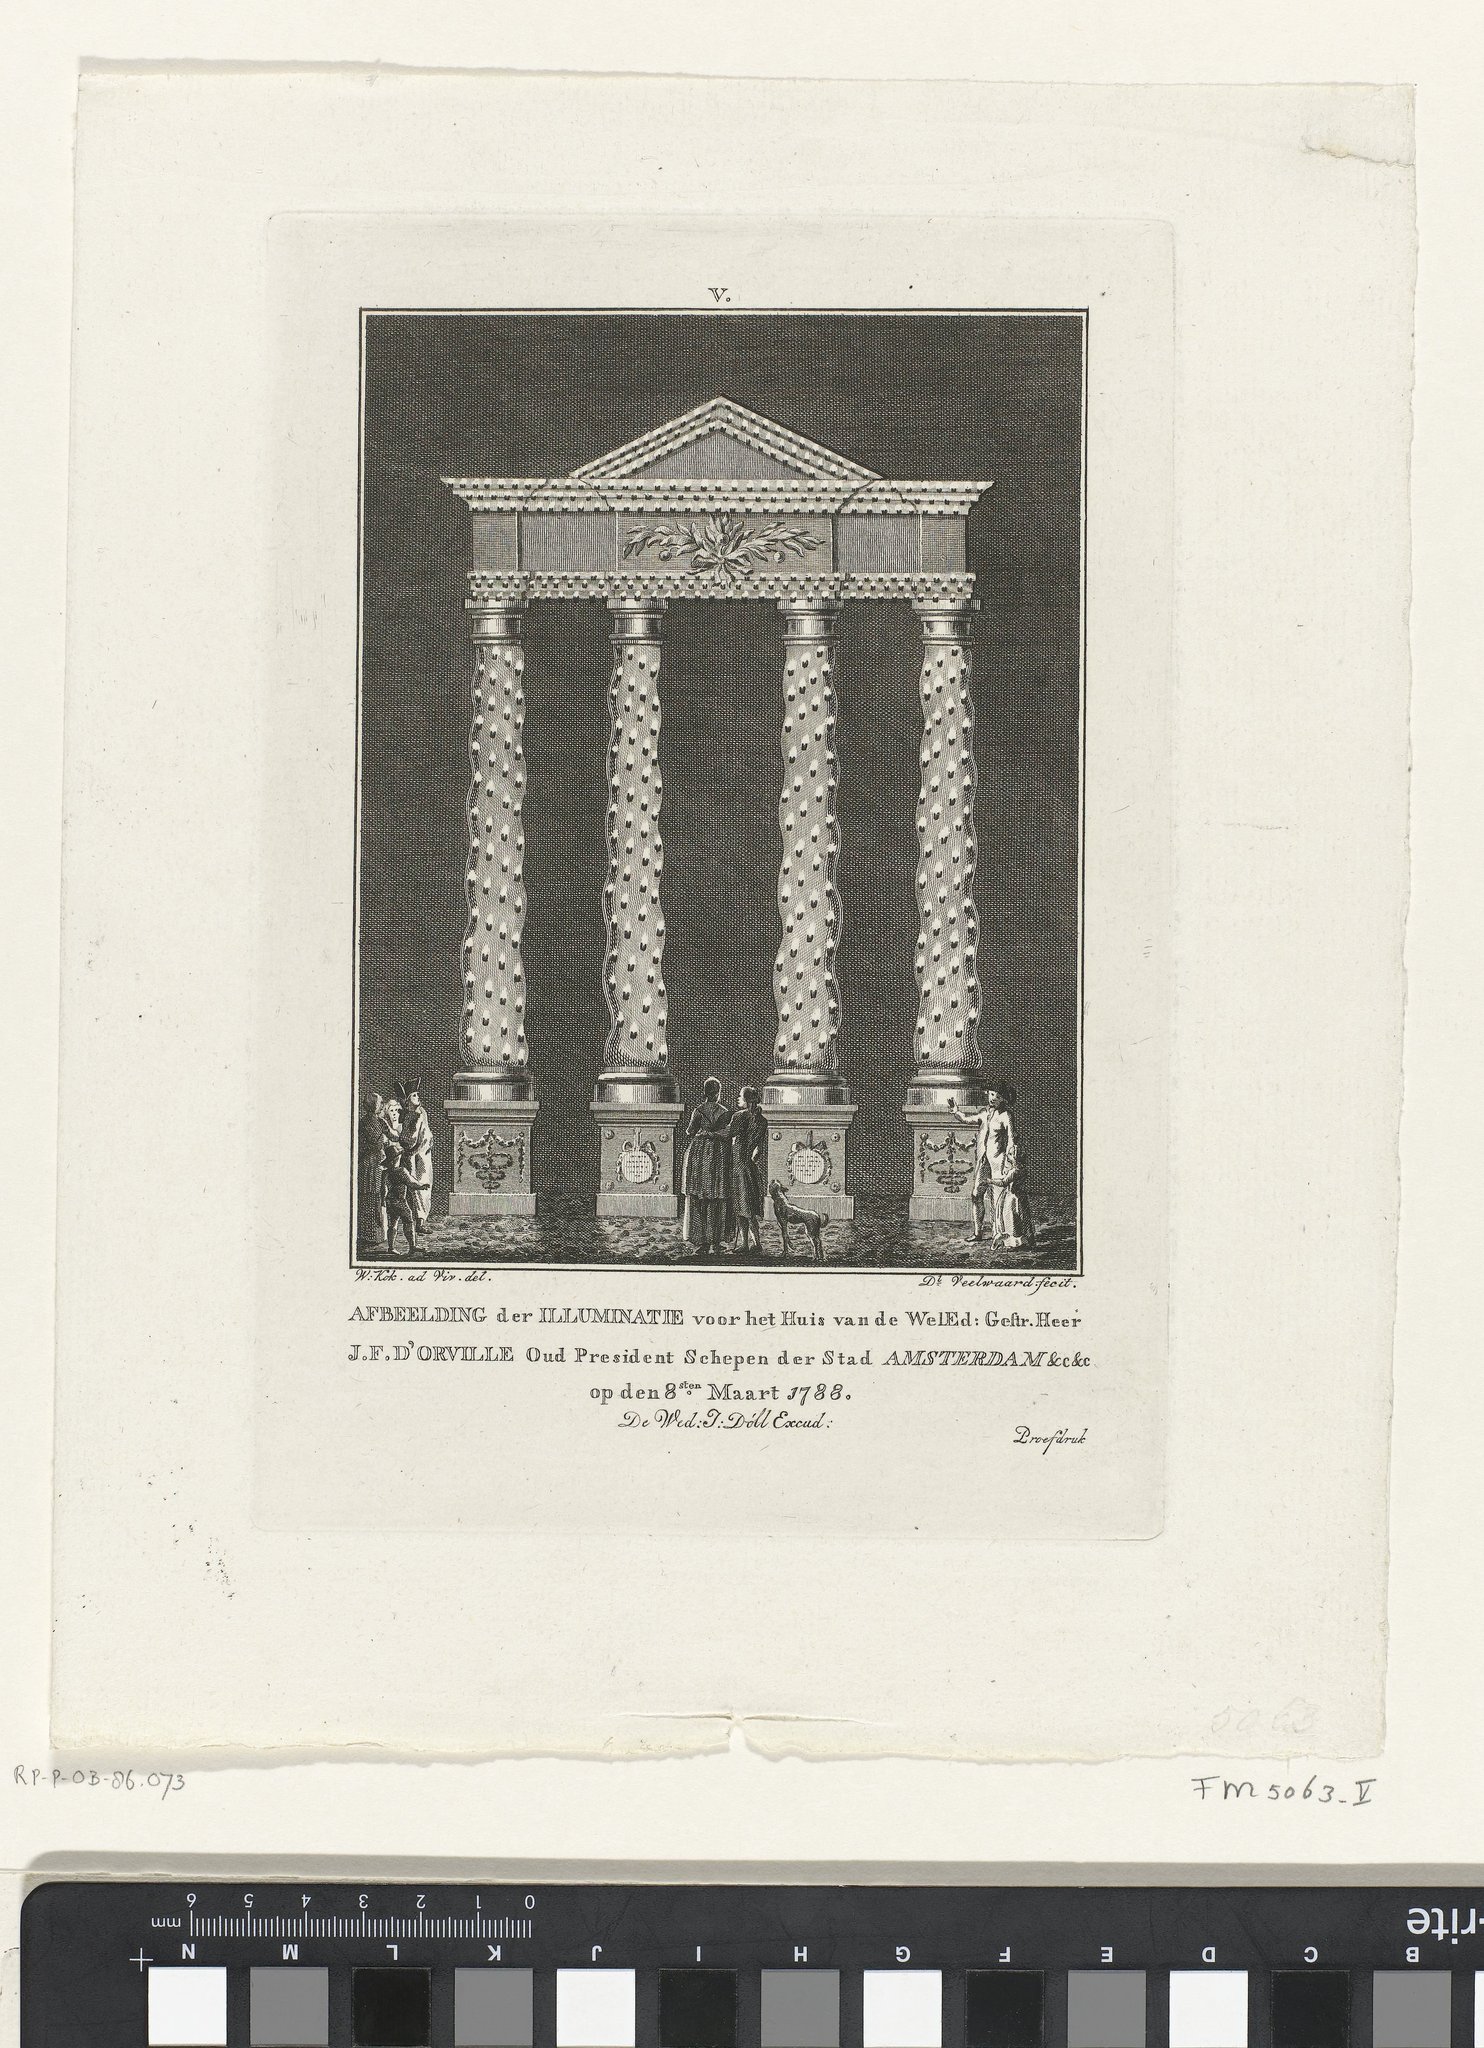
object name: print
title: Afbeelding der Illuminatie voor het Huis van de WelEd: Gestr. Heer J.F. d'Orville Oud President Schepen der Stad Amsterdam, op den 8sten Maart 1788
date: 1788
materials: paper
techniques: engraving, etching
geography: amsterdam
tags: the hague, william v (prince of orange), bonfire, fire-works (+ illumination, fire-works ~ festive activities), amsterdam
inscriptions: collector's mark: Lugt 2228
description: Illuminatie aangebracht voor het huis van J.F. d'Orville te Amsterdam. Genummerd bovenaan: V. Onderdeel van een reeks van twaalf platen van de illuminaties en decoraties te Amsterdam op de 40ste verjaardag van prins Willem V op 8 maart 1788.